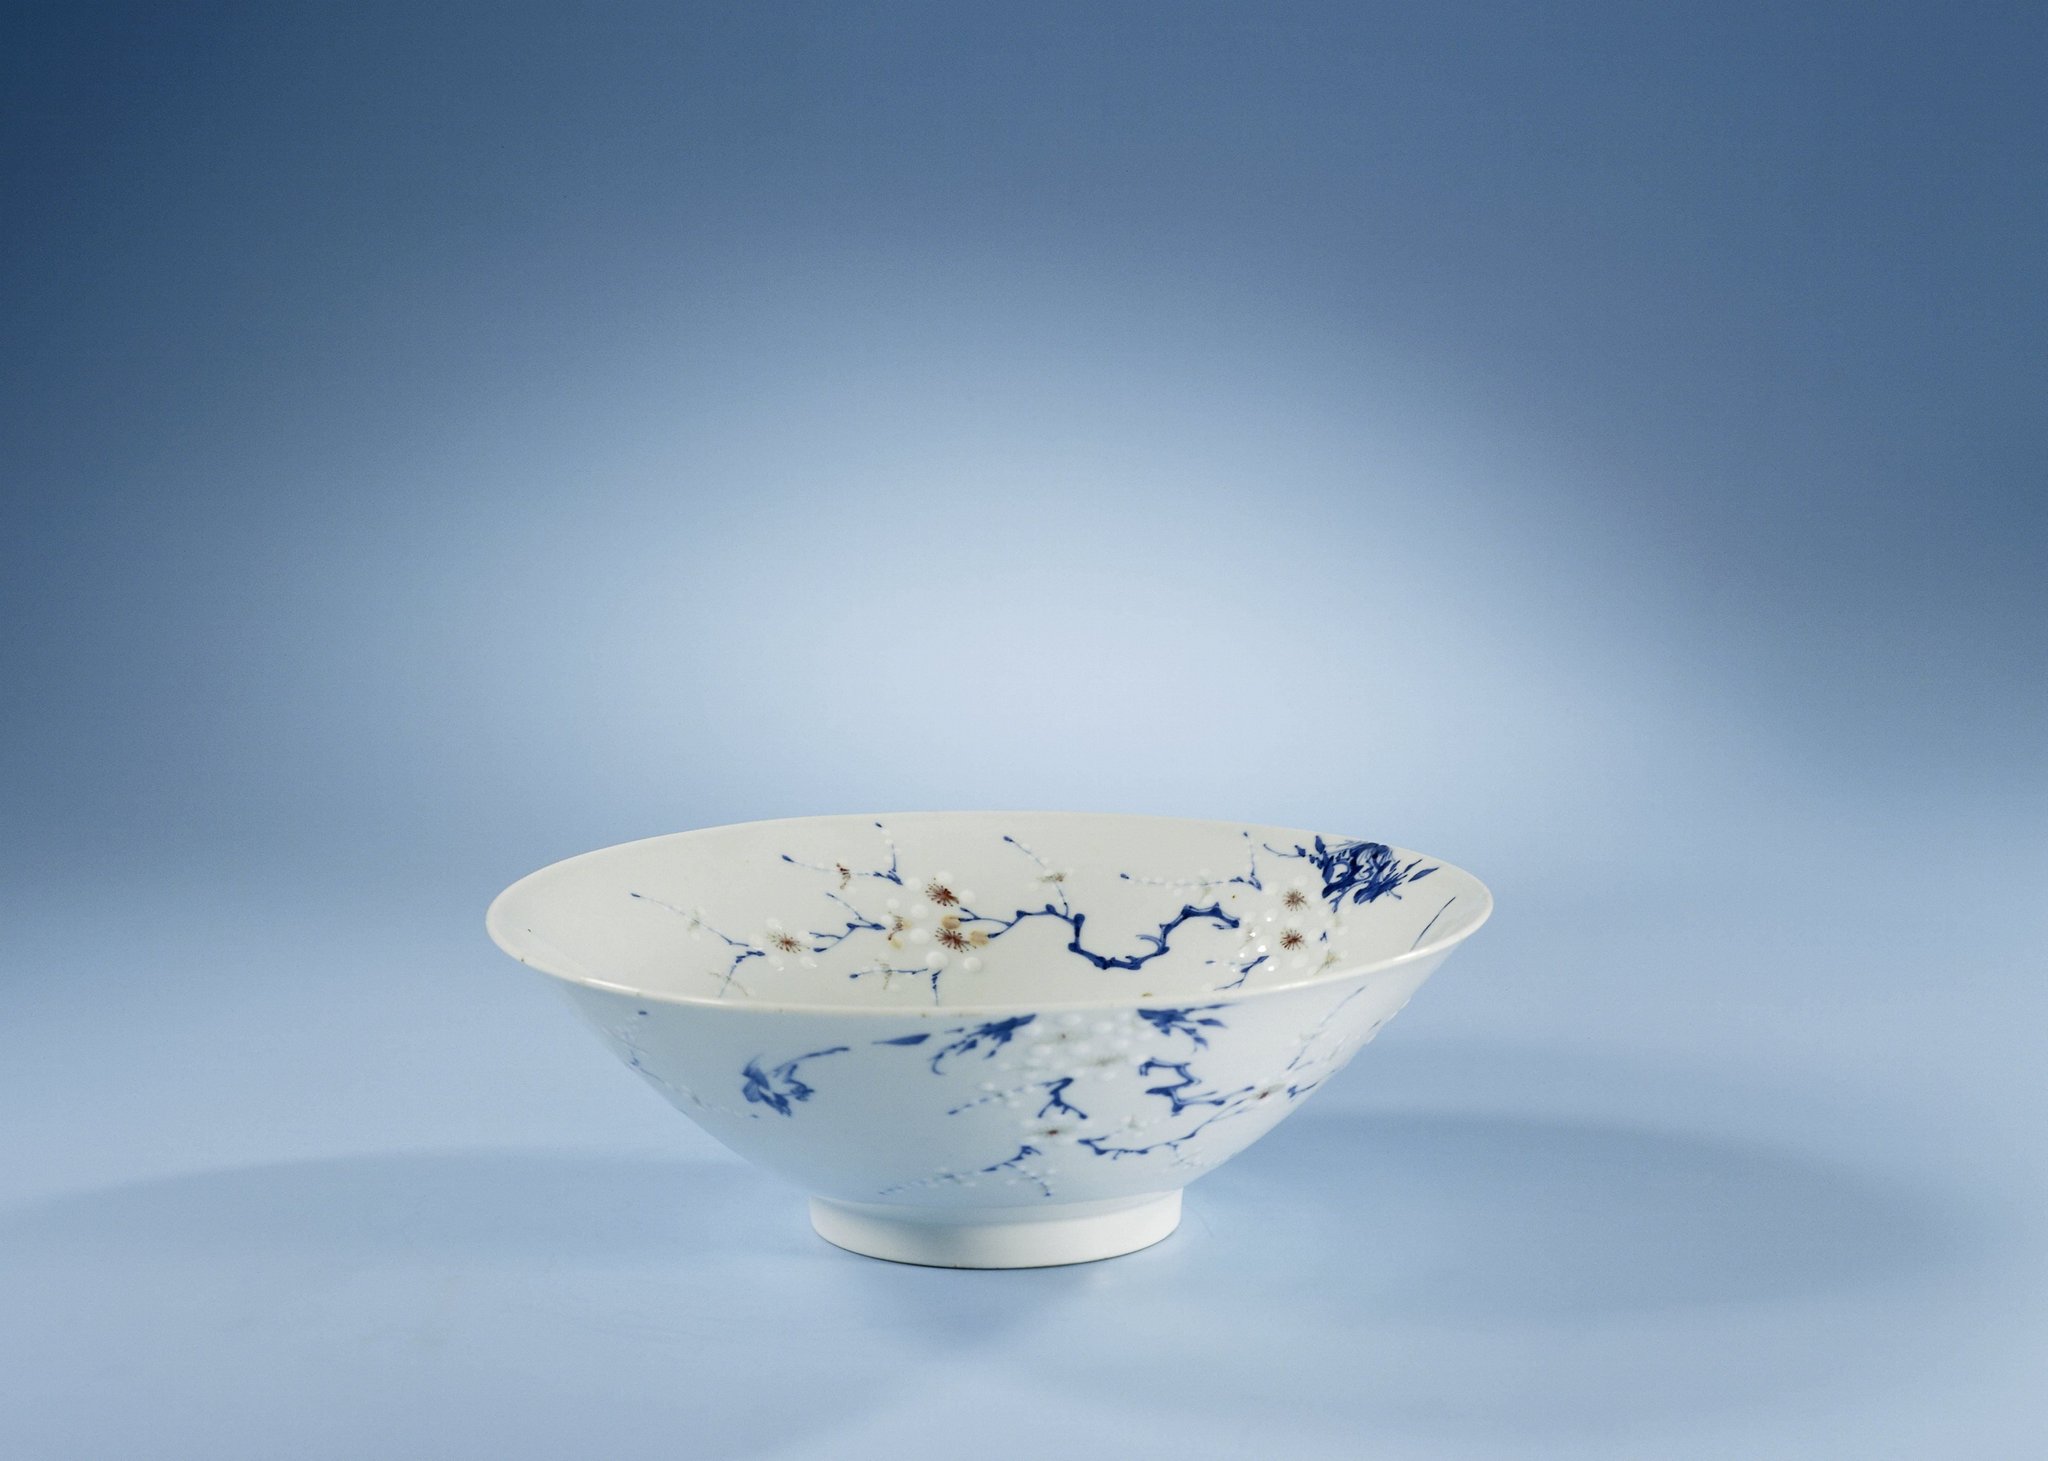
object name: bowl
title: Bowl wit prunus sprays and birds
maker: Anonymous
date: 1660-1680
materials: cobalt, copper, glaze, paint, porcelain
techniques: firing, turning, vitrification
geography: china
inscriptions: mark: ‘制 Zhì’